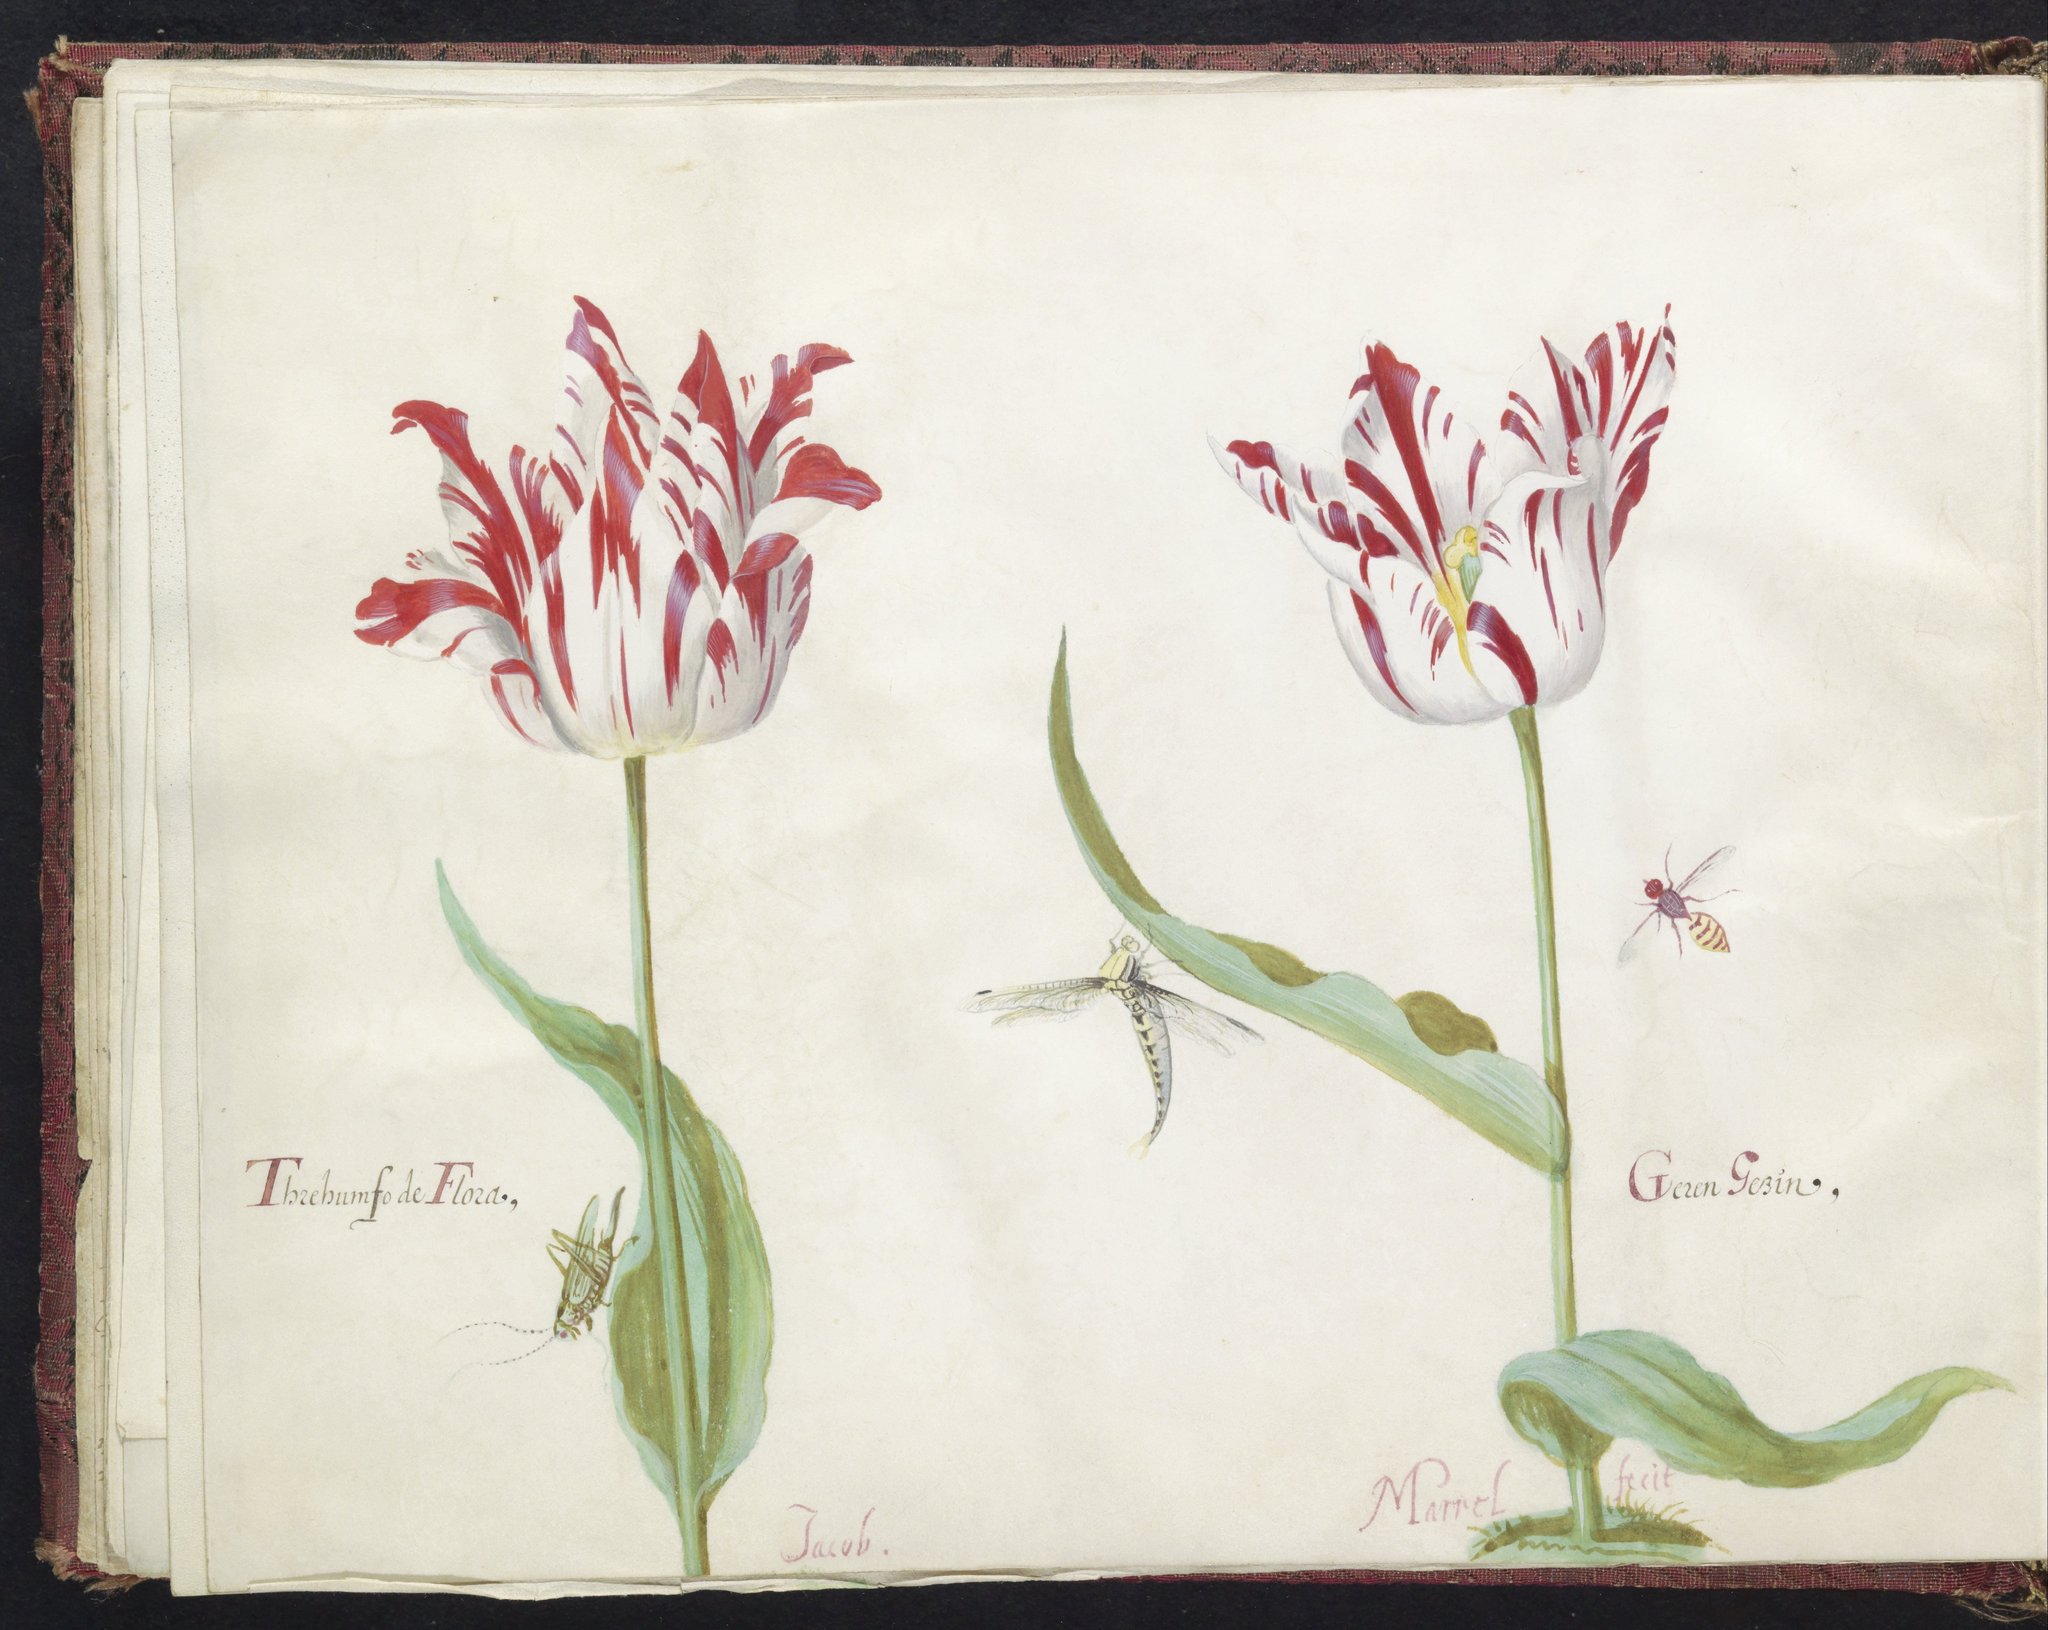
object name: album leaf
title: Twee tulpen met drie insecten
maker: jacob marrel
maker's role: draughtsman, painter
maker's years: 1614-1681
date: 1637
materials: paint, parchment, pencil, watercolor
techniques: brush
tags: flowers: tulip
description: De tekening maakt deel uit van een album.